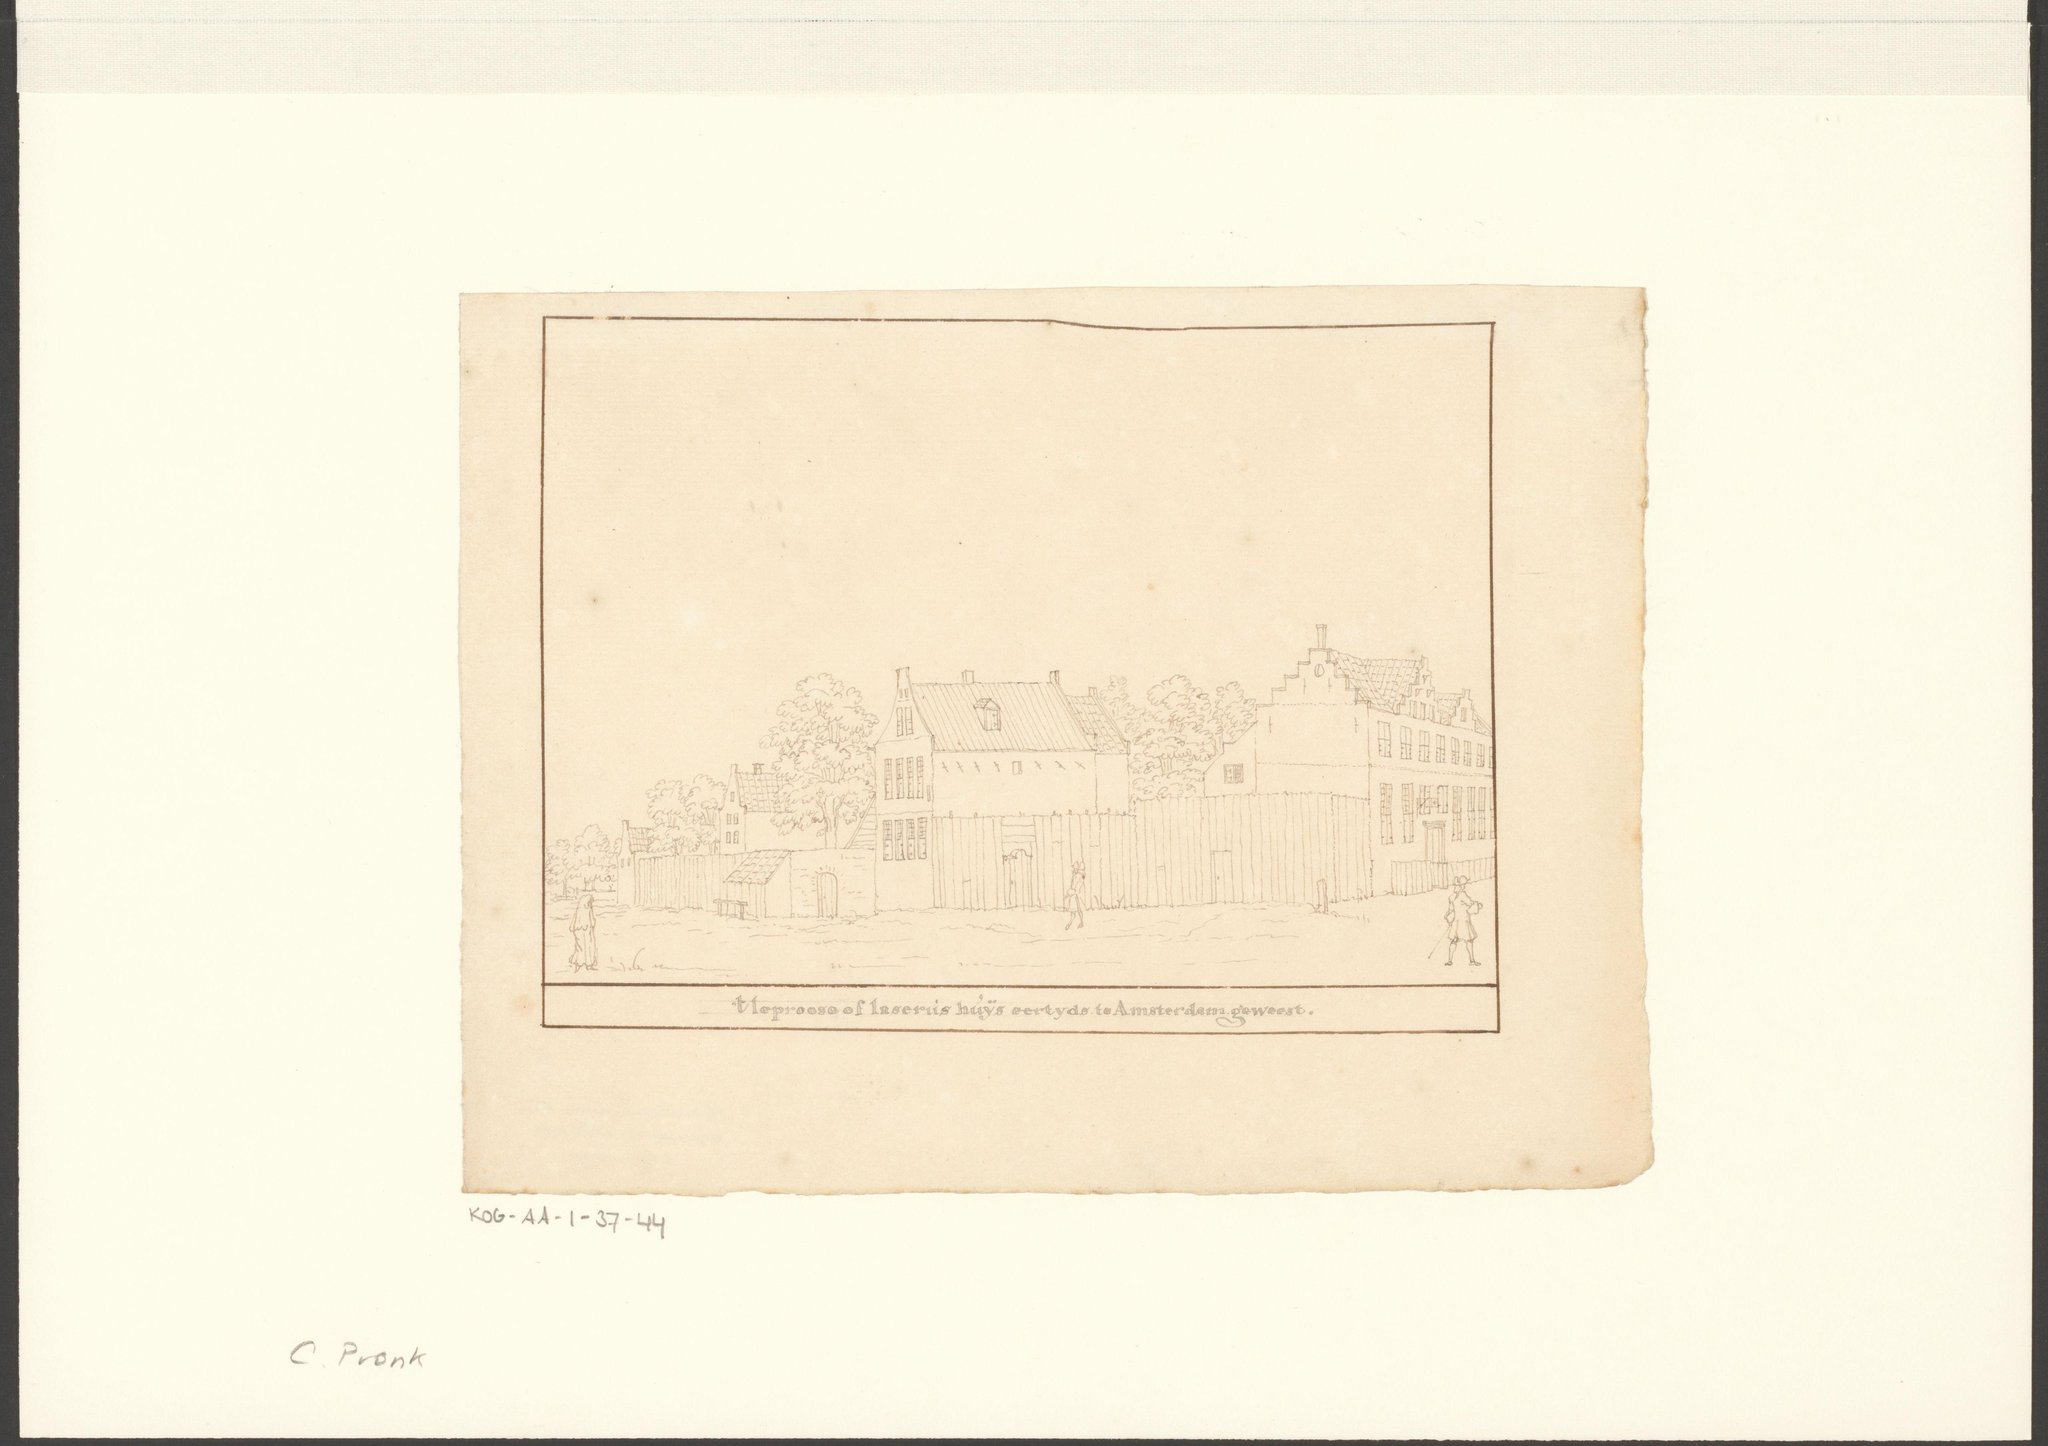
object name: drawing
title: Gezicht op het Leprozenhuis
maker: cornelis pronk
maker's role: draughtsman, painter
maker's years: 1691-1759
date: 1701-1759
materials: ink, paper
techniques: pen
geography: amsterdam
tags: city-view in general; 'veduta', specialized institutions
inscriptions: inscription: ‘'t leproose of laserus huijs eertyds te Amsterdam geweest.’, inscription: ‘Geschenk van de / gemeente Utrecht / Apr. 1877’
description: Onderwerpsrubriek binnen de Atlas Amsterdam: Leprozen- of Lazarushuis, omgang van leprozen, regenten.